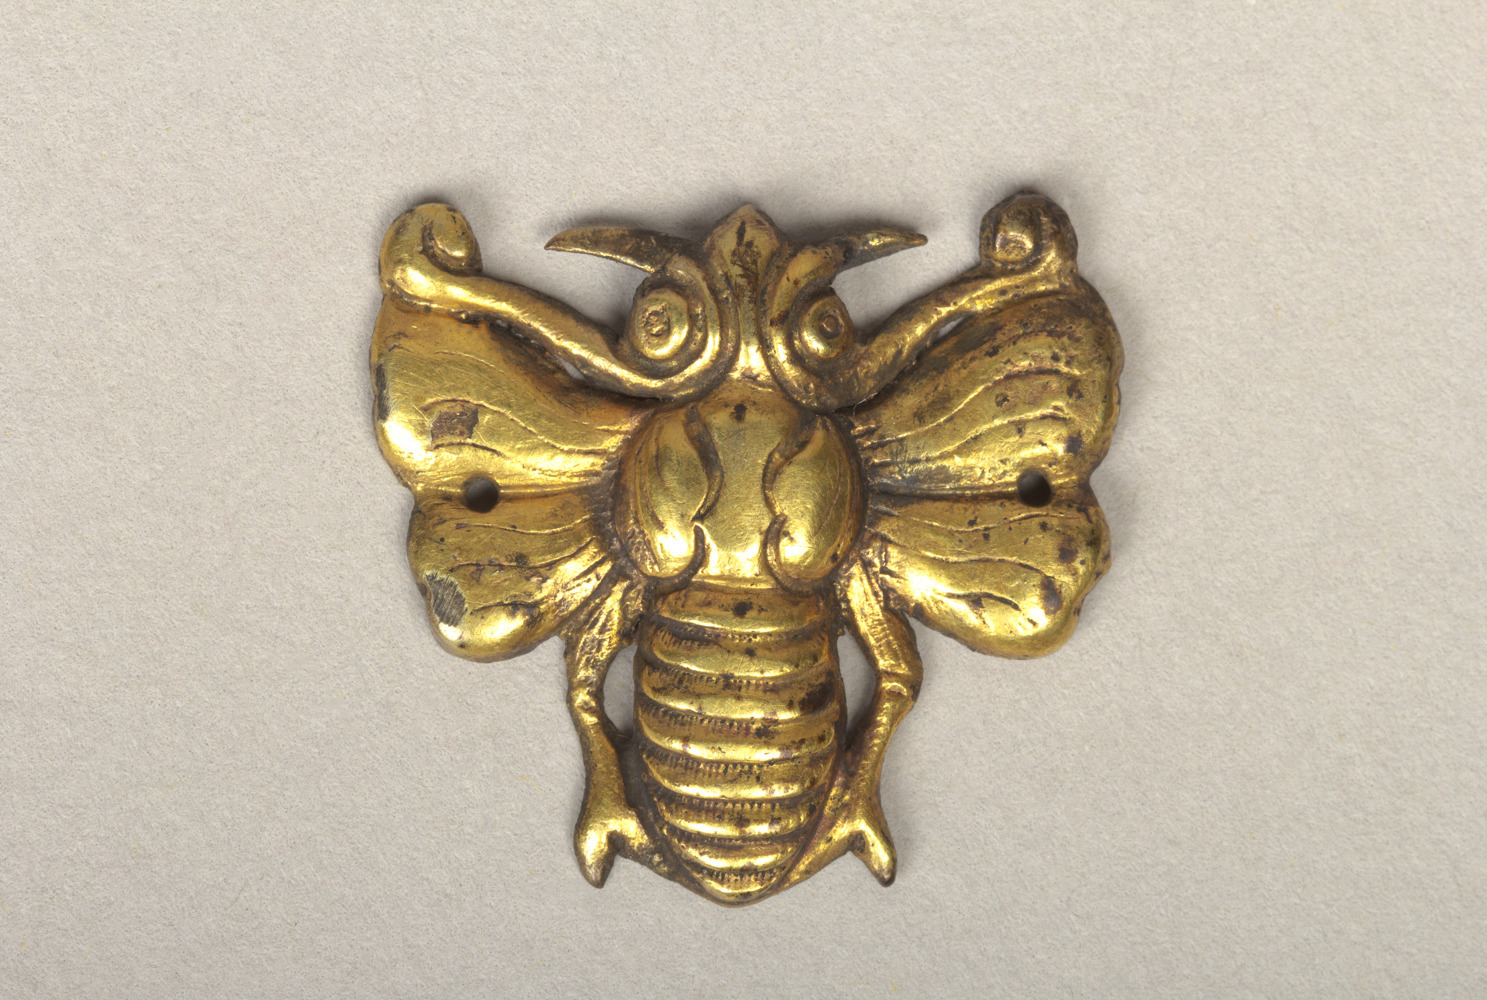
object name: ornament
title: Bee-shaped ornament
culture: korean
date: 918-1392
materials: gold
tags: bees